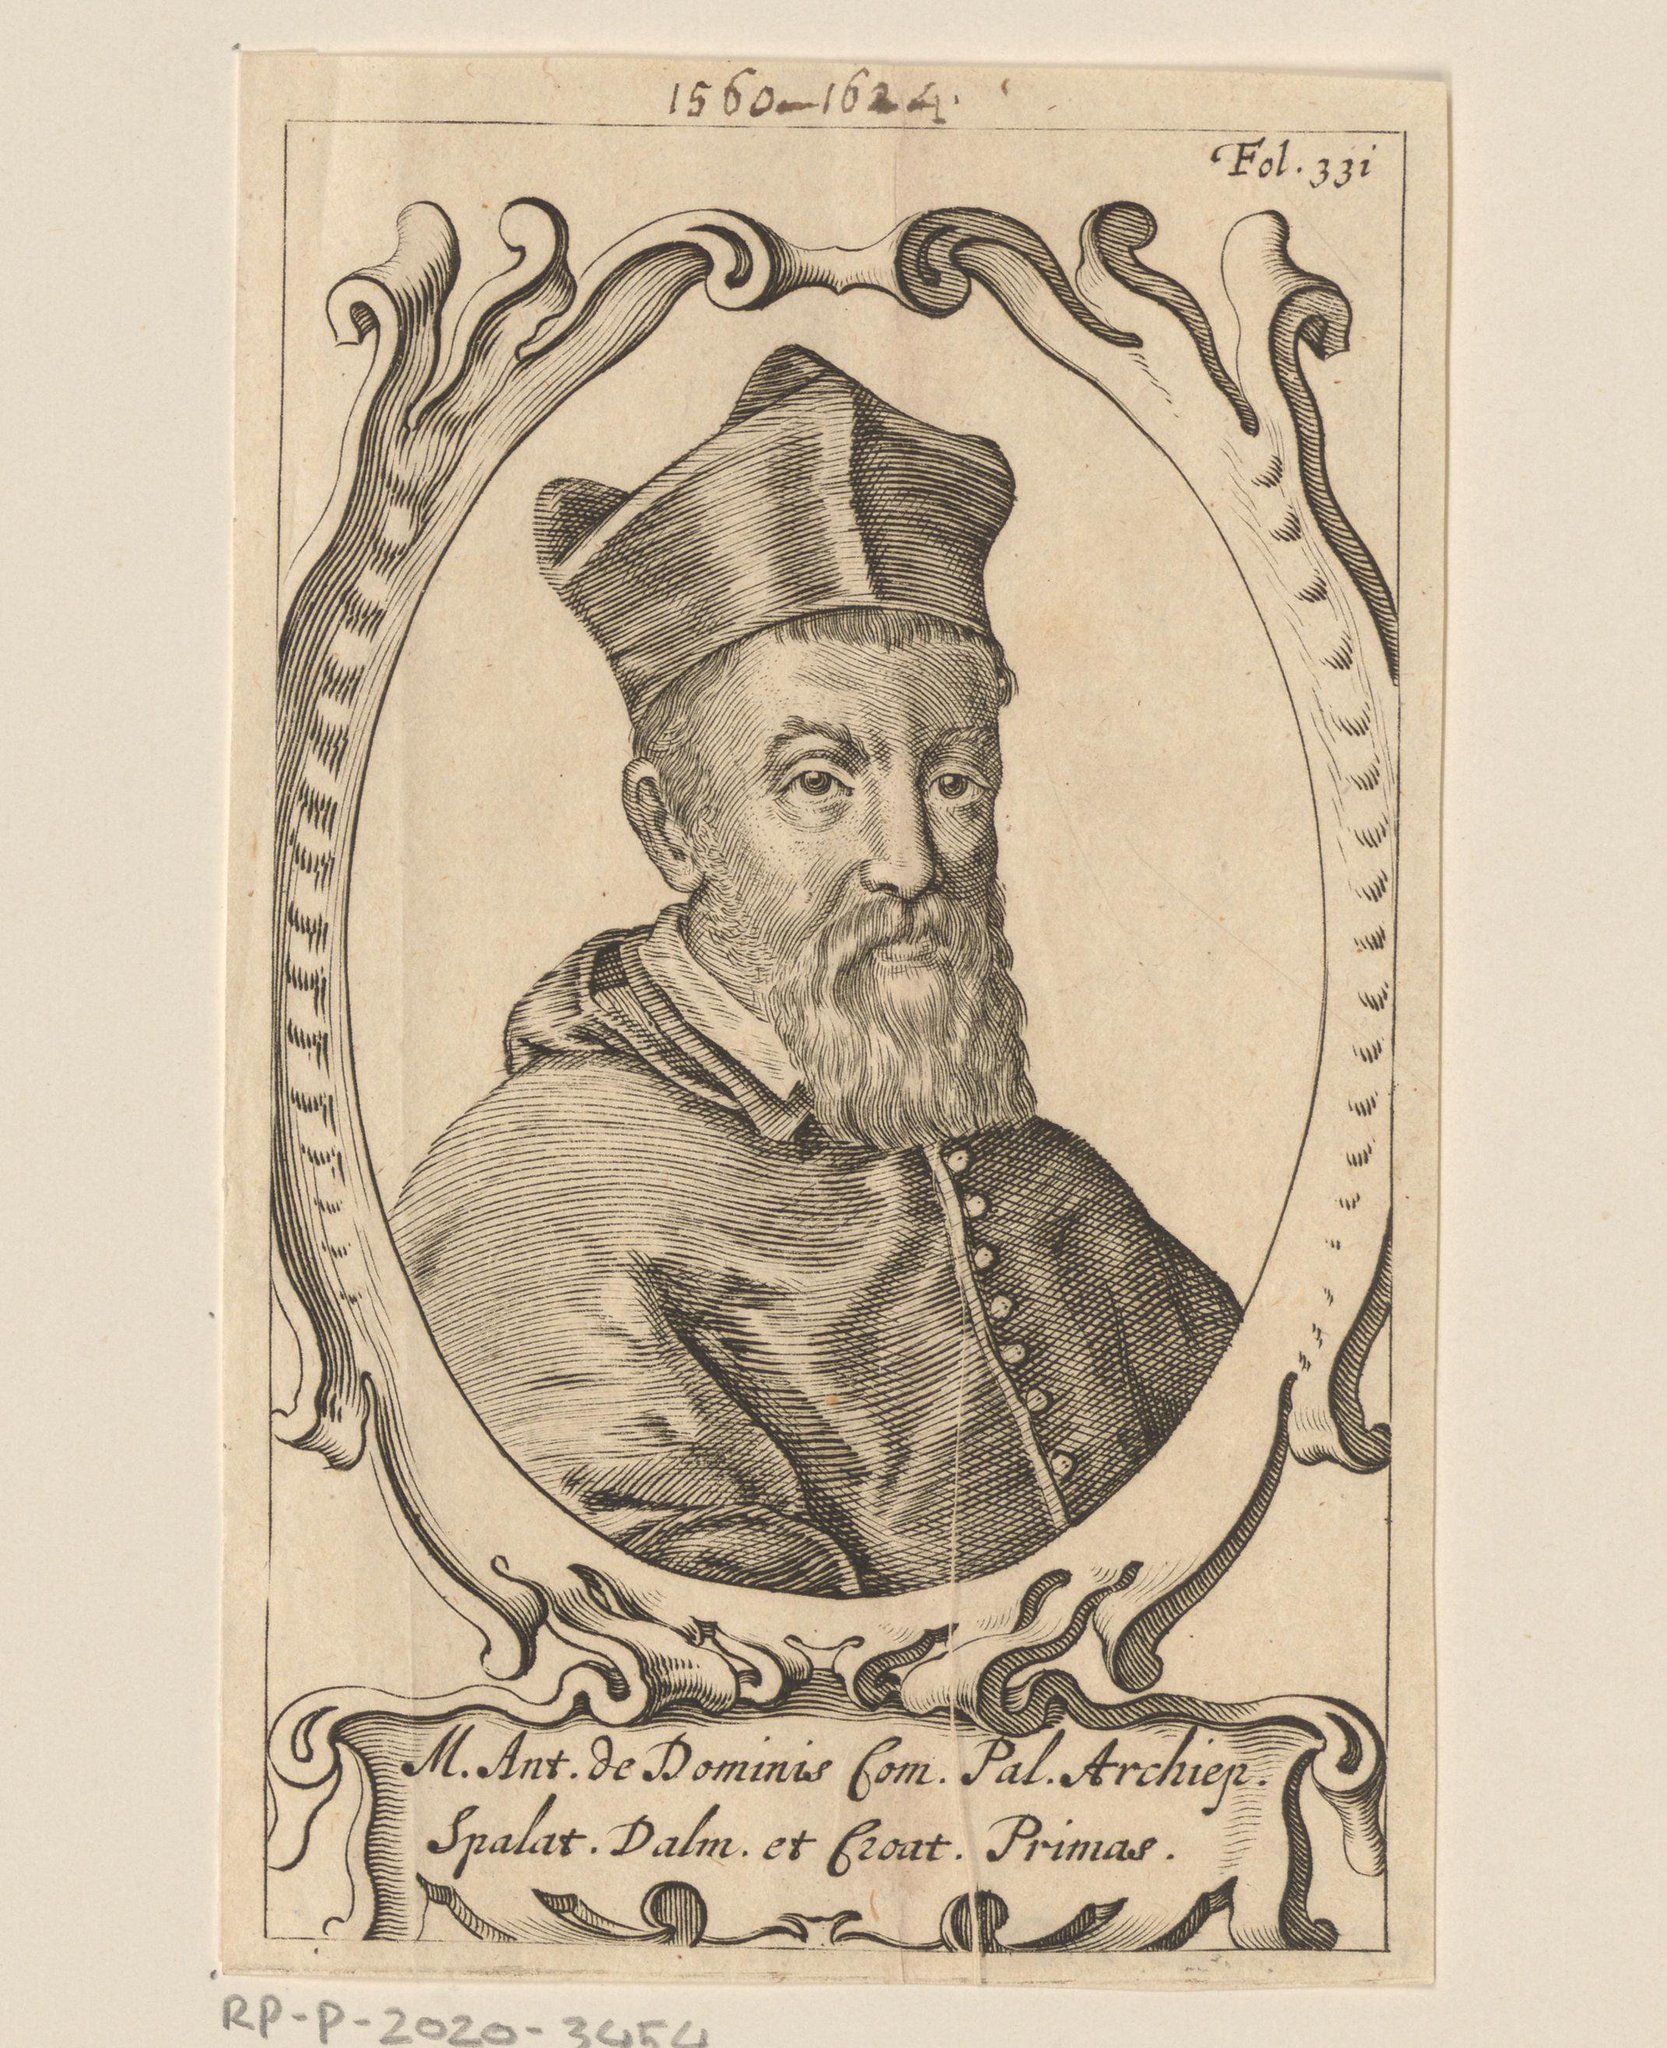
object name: print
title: Portret van Marcus Antonius De Dominis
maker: Anonymous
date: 1600-1699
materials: paper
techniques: engraving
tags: rome, scholar, philosopher, historical persons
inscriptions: inscription: ‘1560-1624’